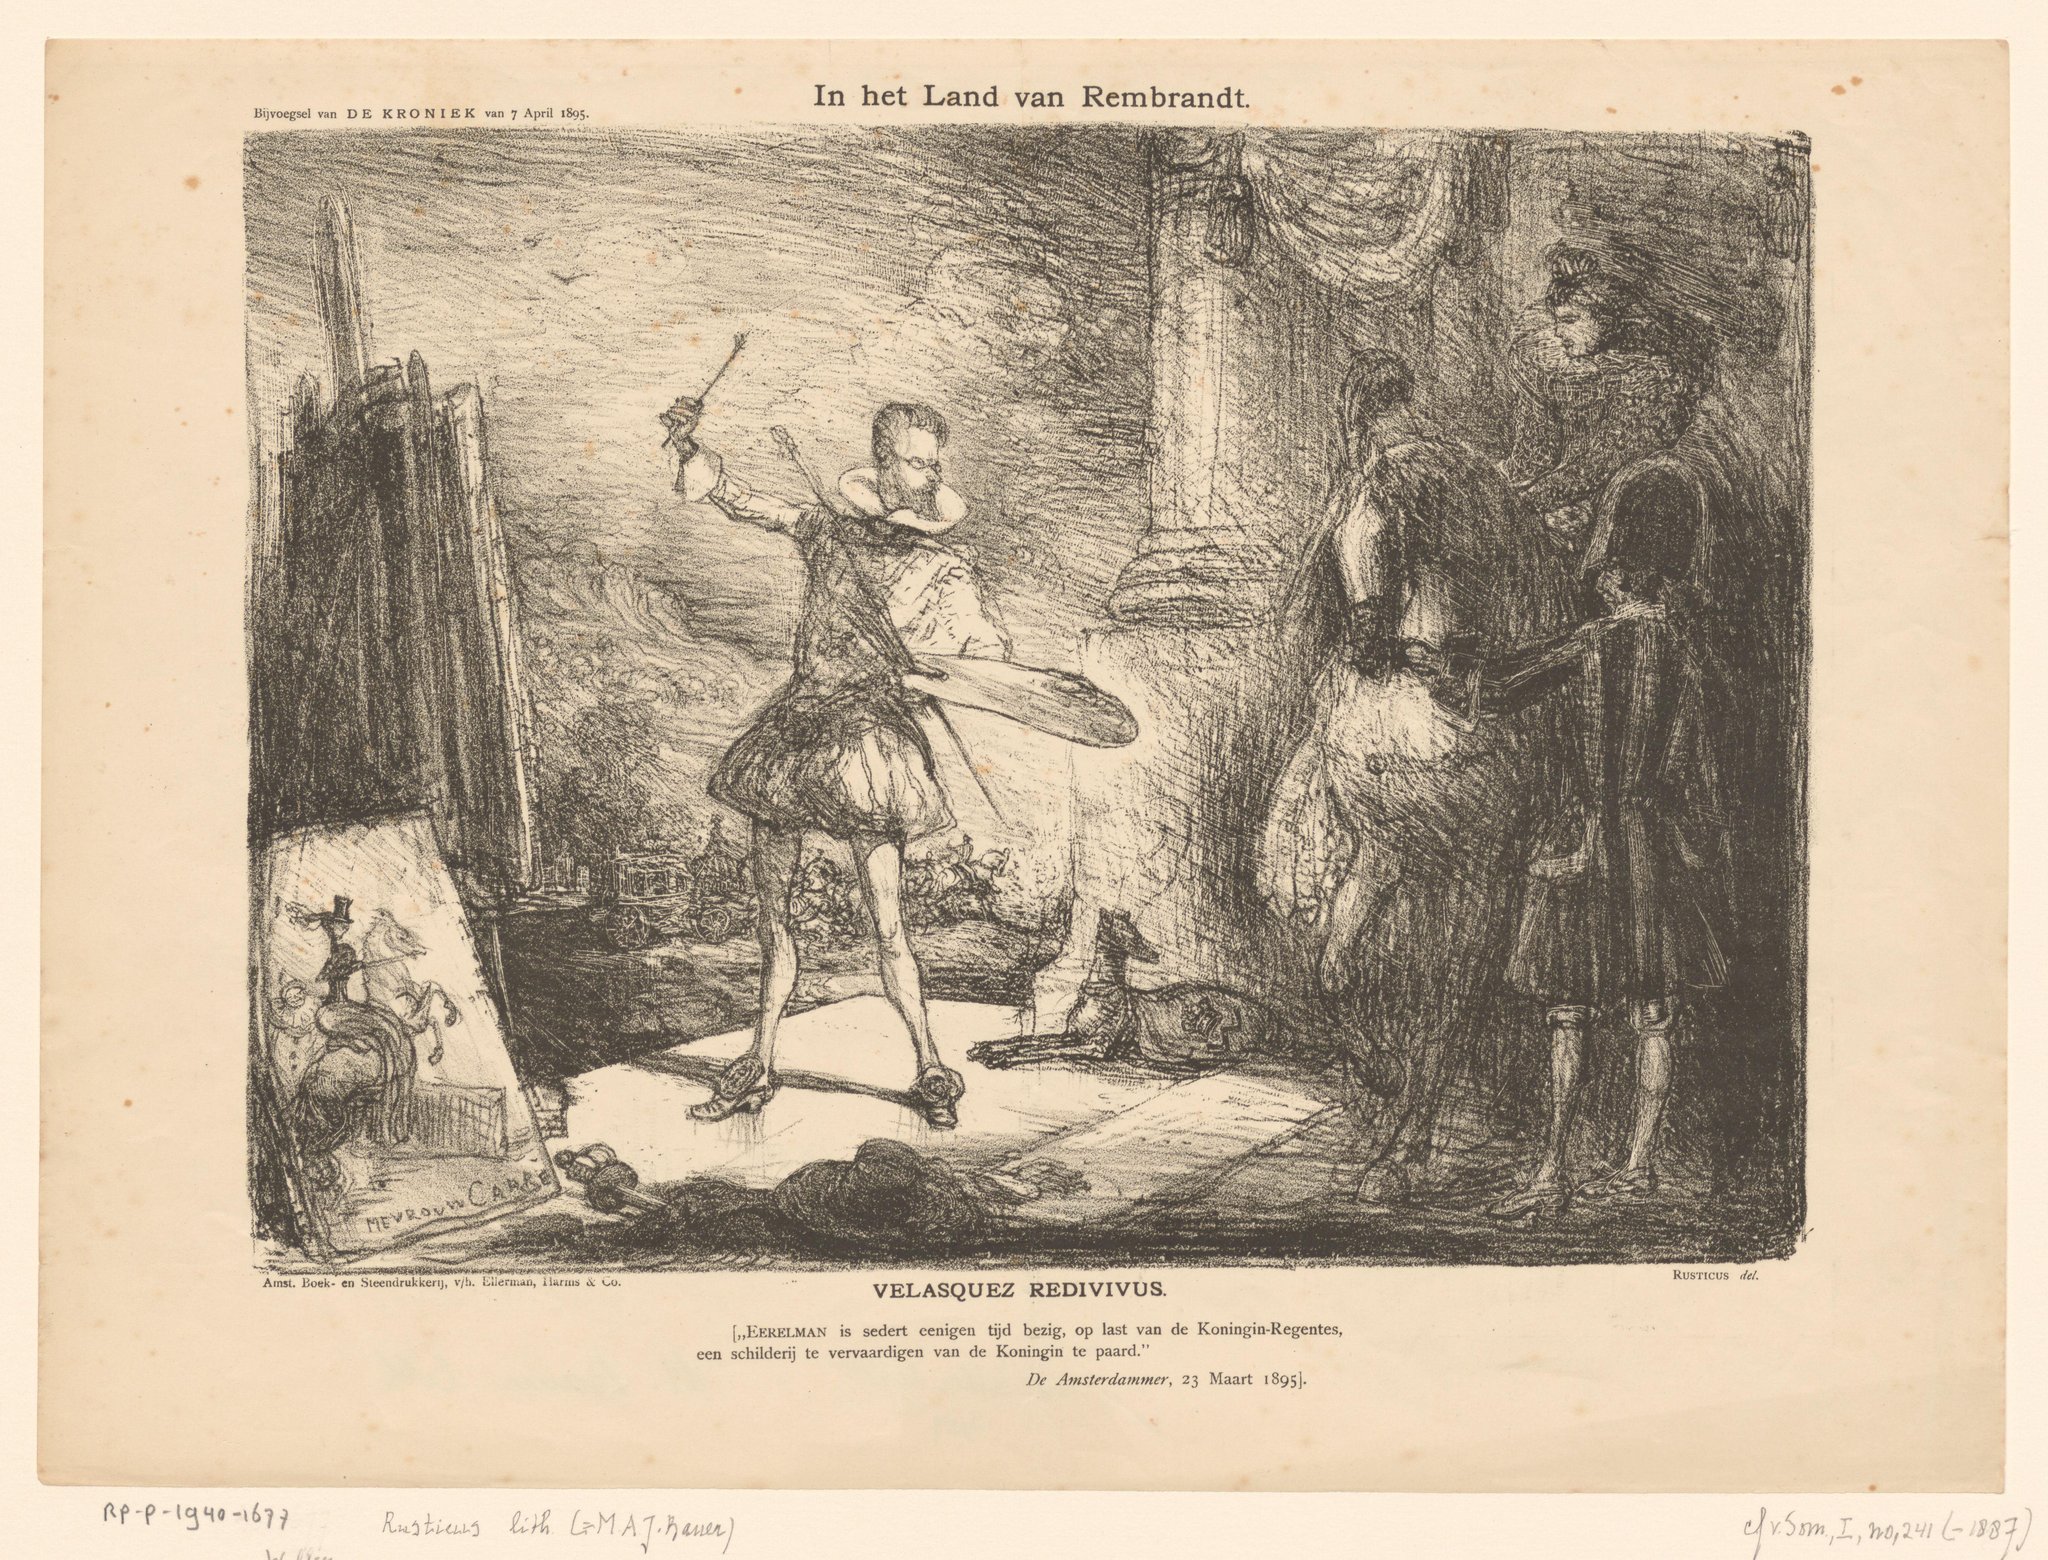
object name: print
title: Karikatuur van Otto Eerelman als Diego Velázquez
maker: marius bauer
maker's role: draughtsman, print maker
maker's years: 1867-1932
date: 1895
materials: paper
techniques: lithograph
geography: netherlands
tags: the hague, print maker, wilhelmina of the netherlands, sevilla, diego rodriguez de silva y velázquez, painter, draughtsman, otto eerelman, historical persons - bb - woman, historical persons, model, sitter ~ painting, painter at work, in his studio, political caricatures and satires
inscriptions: inscription: ‘uit Kelder dépôt/ 2002’, collector's mark: Lugt 2166, collector's mark: Lugt 2760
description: Spotprent op de schilder Eerelman die het ruiterportret van de jonge Wilhelmina schildert. Eerelman voorgesteld als Velázquez staande voor zijn ezel, linksvoor op de grond een portret van mevrouw Carré te paard. Onder de voorstelling staat 'Velasquez Redivivus' en twee regels tekst in het Nederlands uit De Amsterdammer van 23 maart 1895.